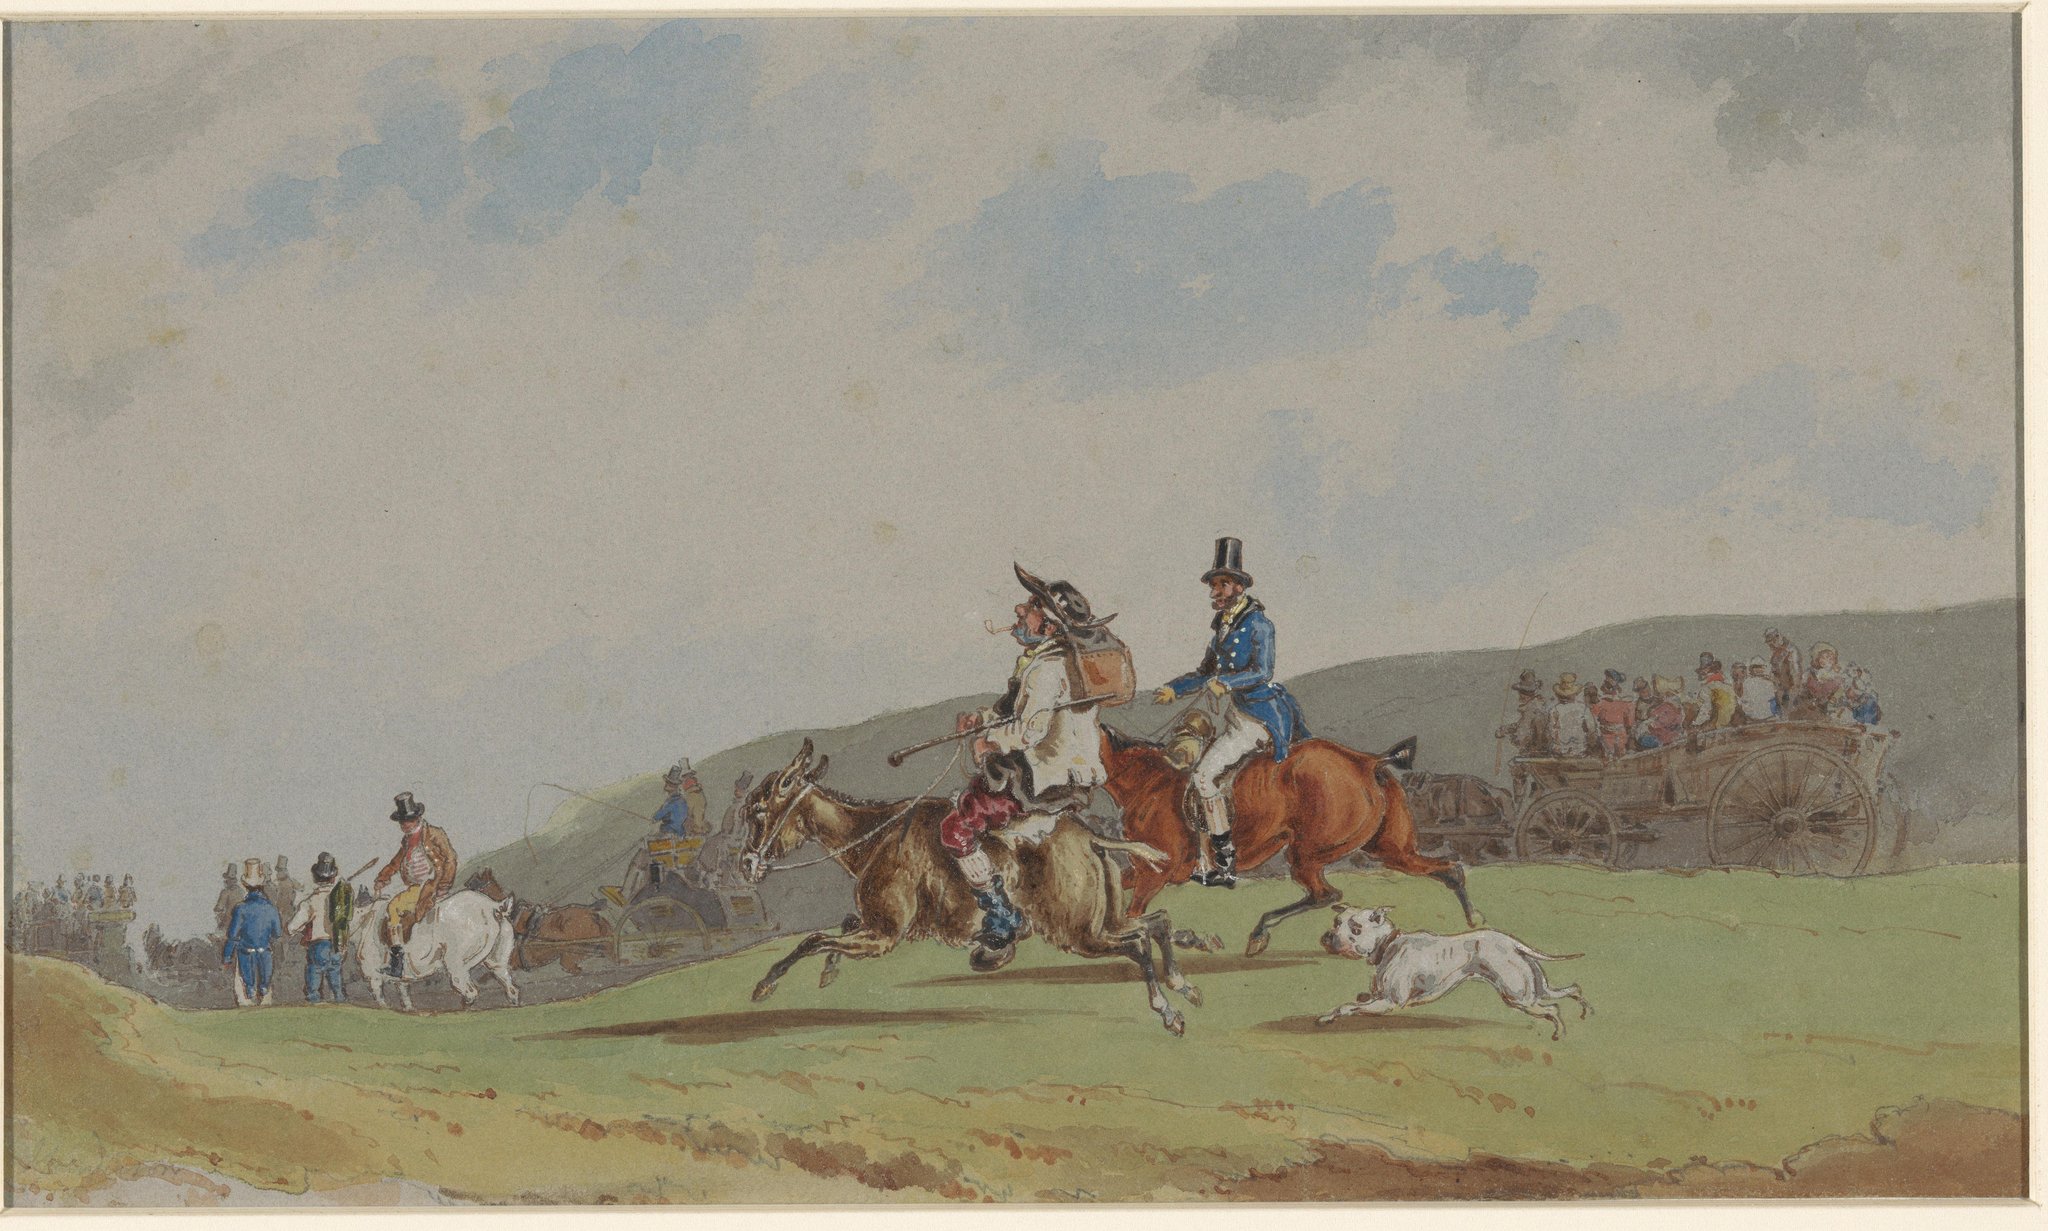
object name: drawing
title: Don Quichot en Sancho Panza (?)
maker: Anonymous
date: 1800-1900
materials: ink, paper, pencil, watercolor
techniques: brush, pen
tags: don quixote, sancho panza